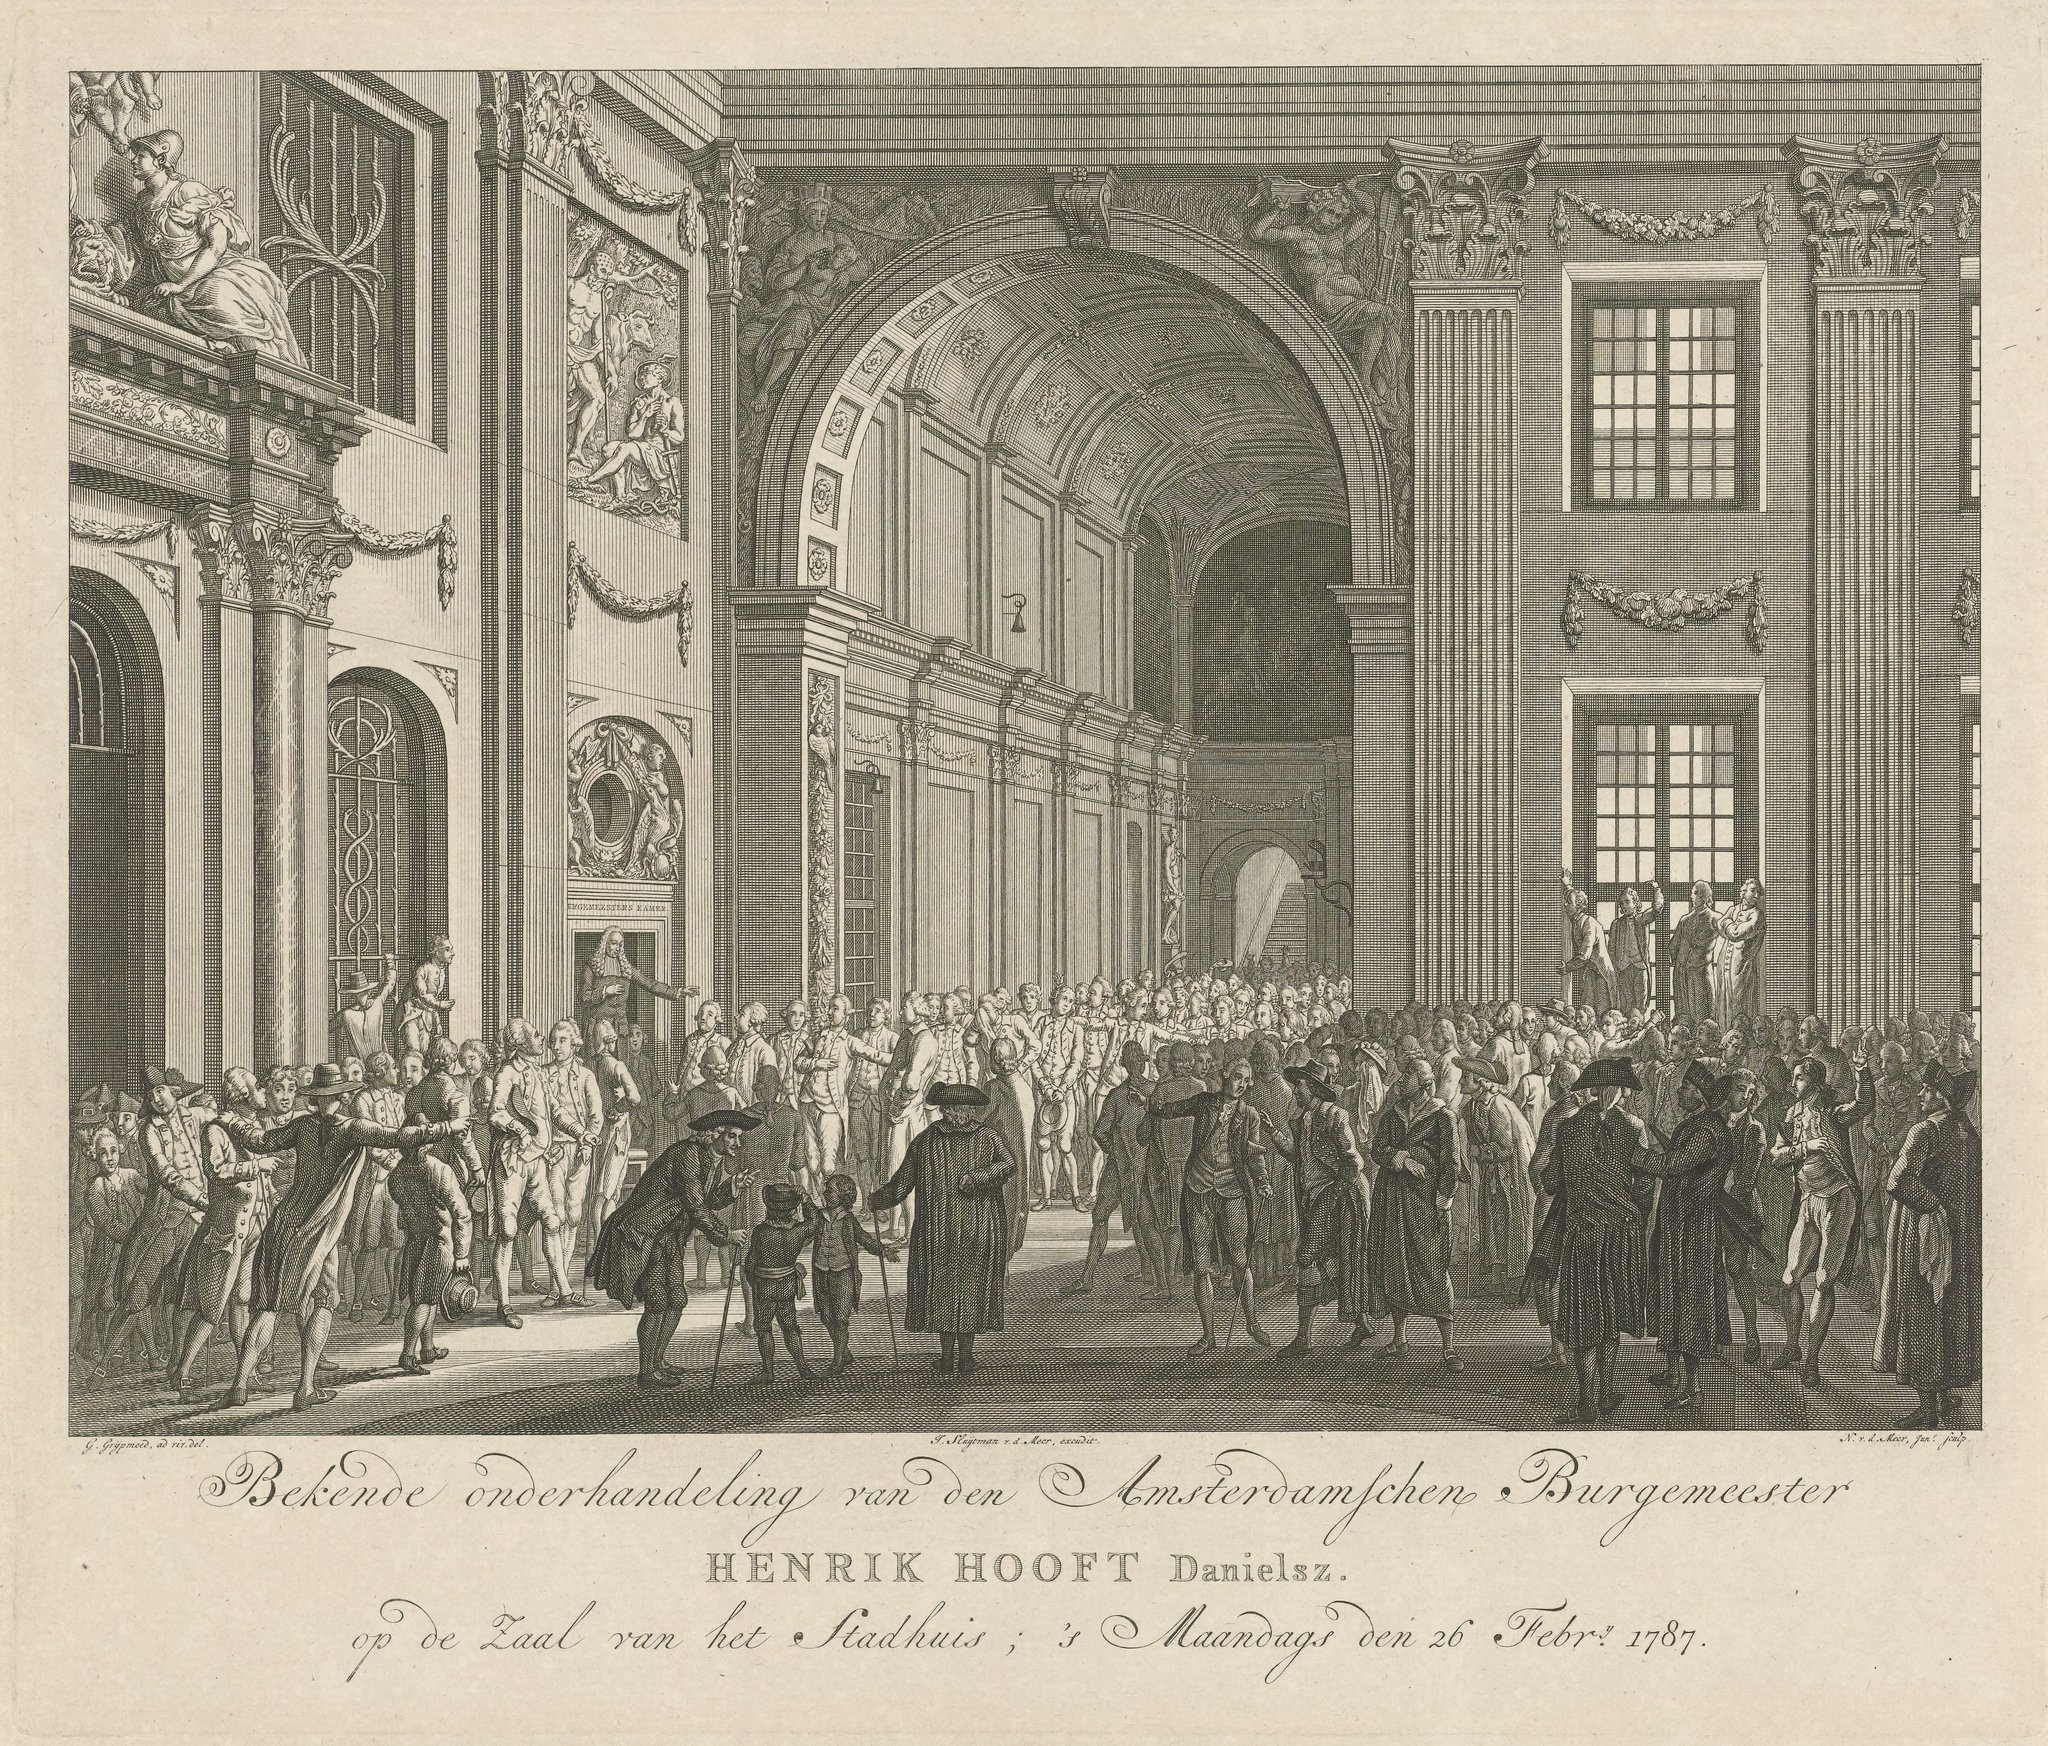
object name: print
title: Bekende onderhandeling van den Amsterdamschen Burgemeester Henrik Hooft Danielsz. op de Zaal van het Stadhuis (...)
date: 1787-1789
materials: paper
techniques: etching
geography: amsterdam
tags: amsterdam, mayor, hendrik danielsz. hooft, crowd, mob, mayor, burgomaster, negotiations, conference ~ diplomacy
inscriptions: collector's mark: Lugt 2228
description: Burgemeester Hendrik Danielsz. Hooft onderhandelt met de burgerij over het regiment van Rijngraaf van Salm in het stadhuis op 26 februari 1787. De burgemeester staat op een verhoging voor de deur van zijn kamer en spreekt de menigte toe.